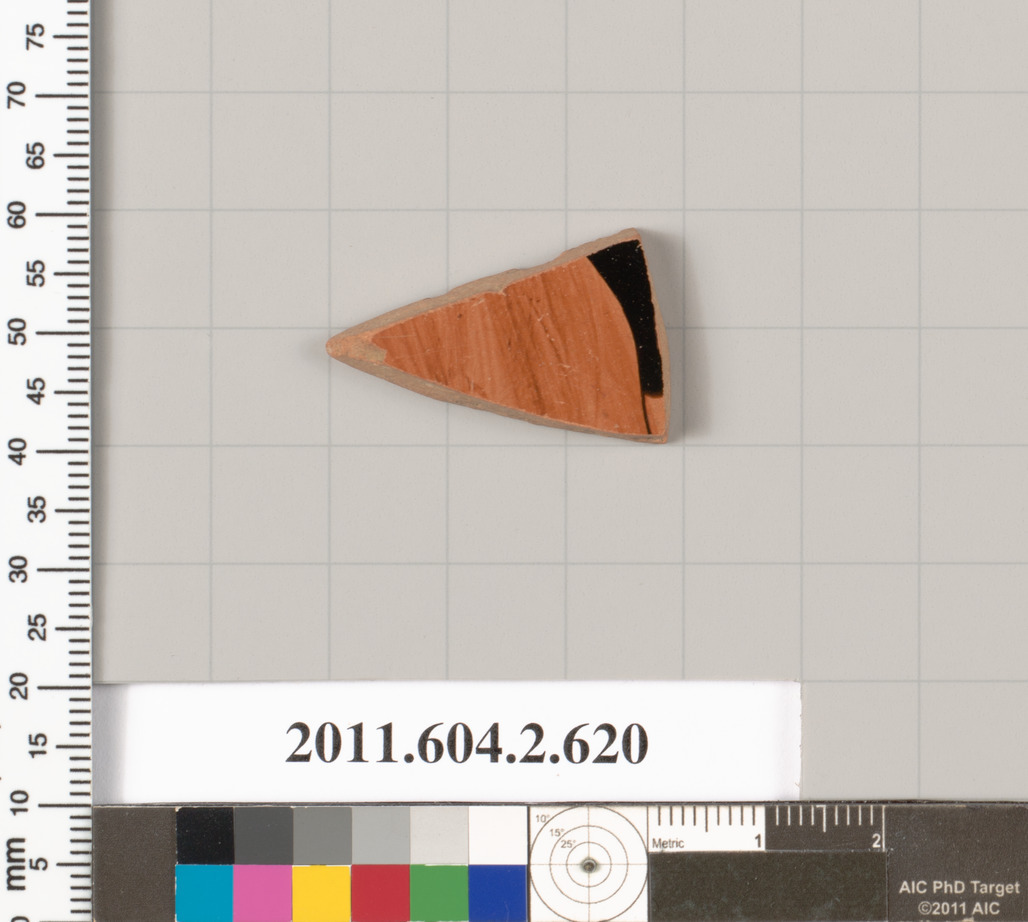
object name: column krater fragment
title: Terracotta fragment of a column-krater (bowl for mixing wine and water)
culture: greek, attic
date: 460-440 BCE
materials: terracotta